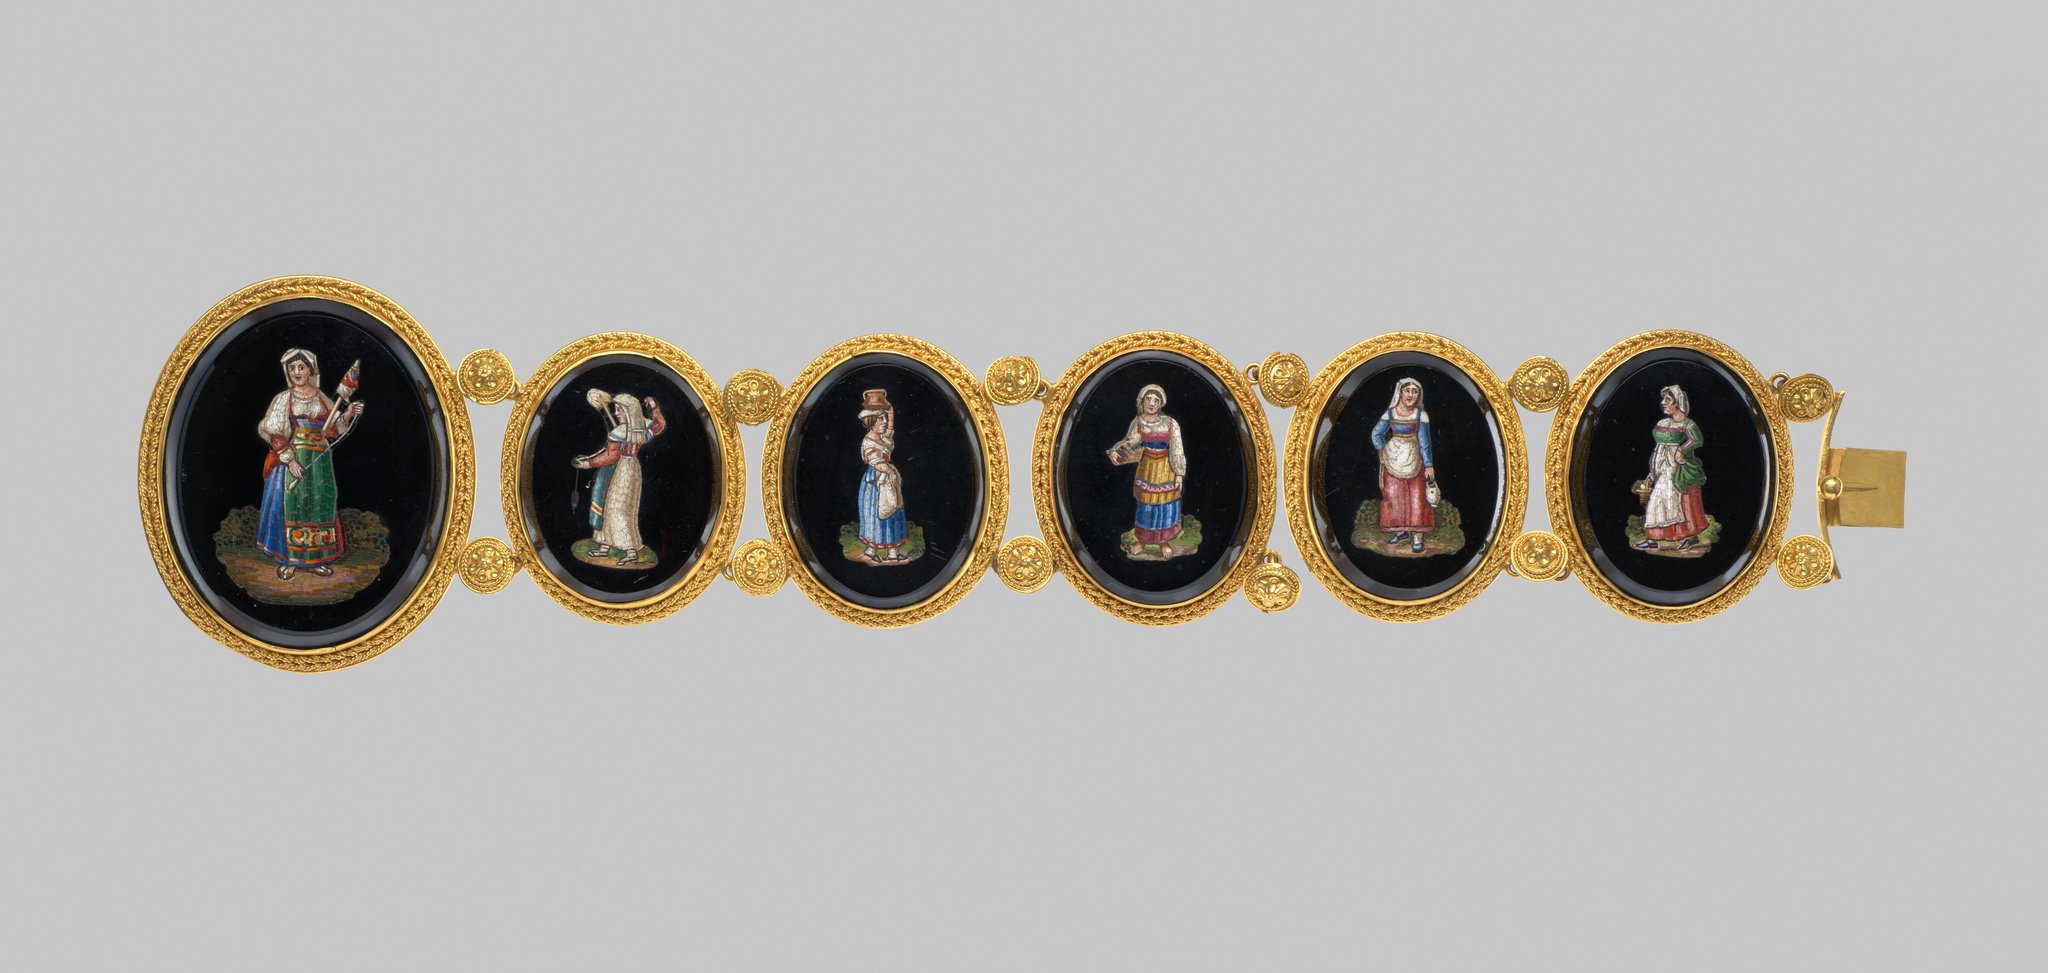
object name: bracelet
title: Bracelet (part of a set)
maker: g.l. barberi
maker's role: artist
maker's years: 1800-1900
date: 1801-1900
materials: gold, onyx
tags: women